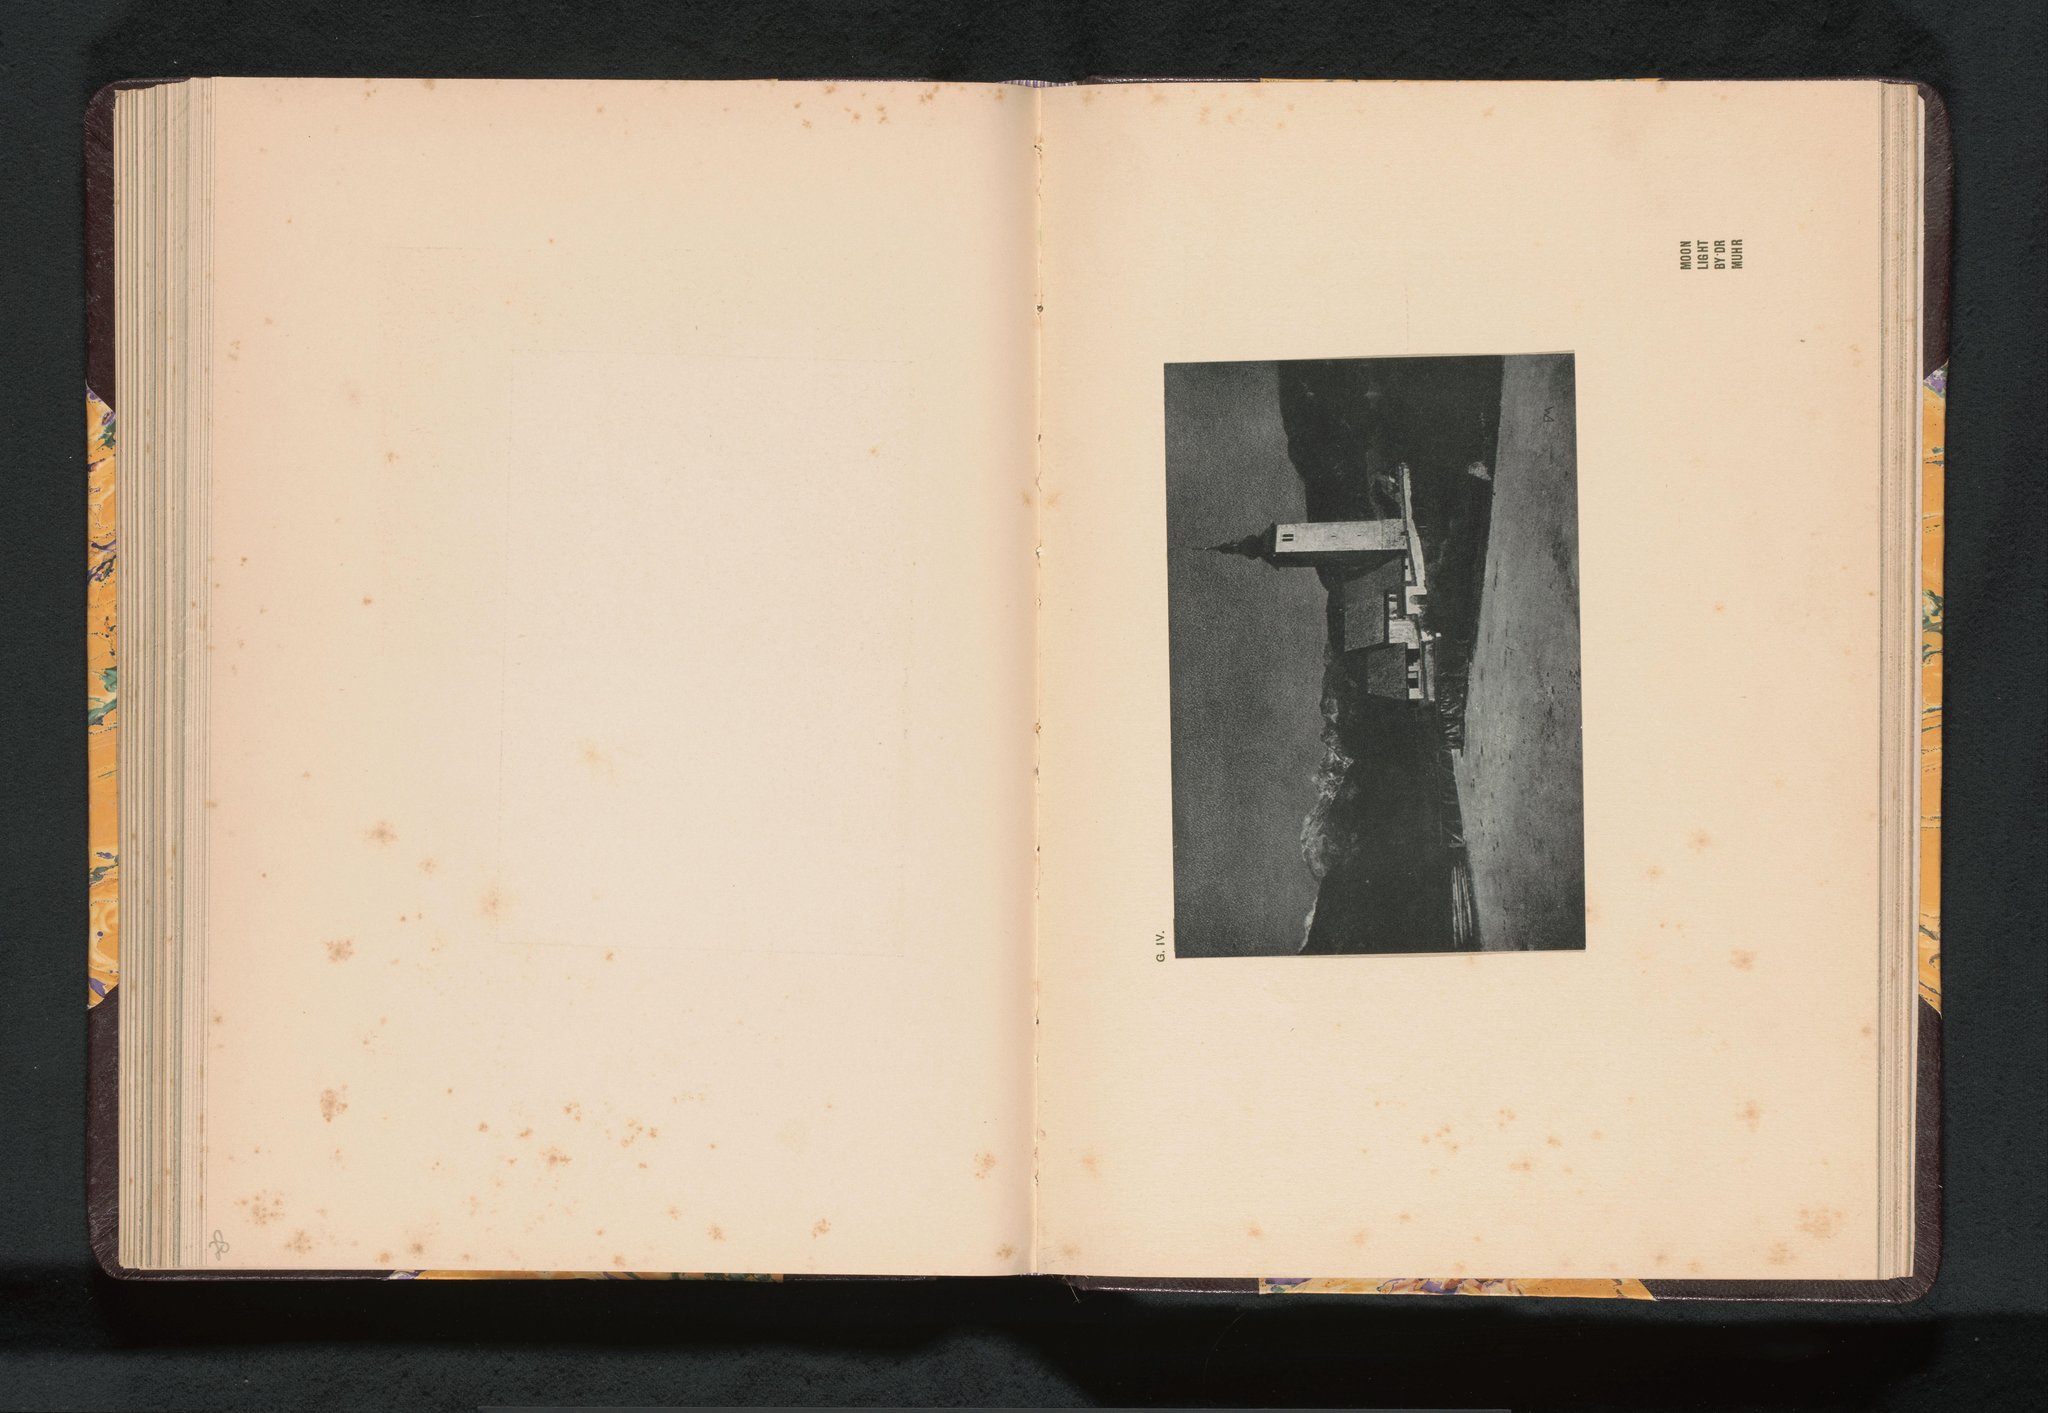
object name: page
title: Gezicht op een kerk in de bergen bij maanlicht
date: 1900-1905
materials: paper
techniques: two-color autotype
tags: moonlight, church (exterior), mountains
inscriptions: inscription: ‘G. IV.’, inscription: ‘Moonlight by Dr. Muhr’